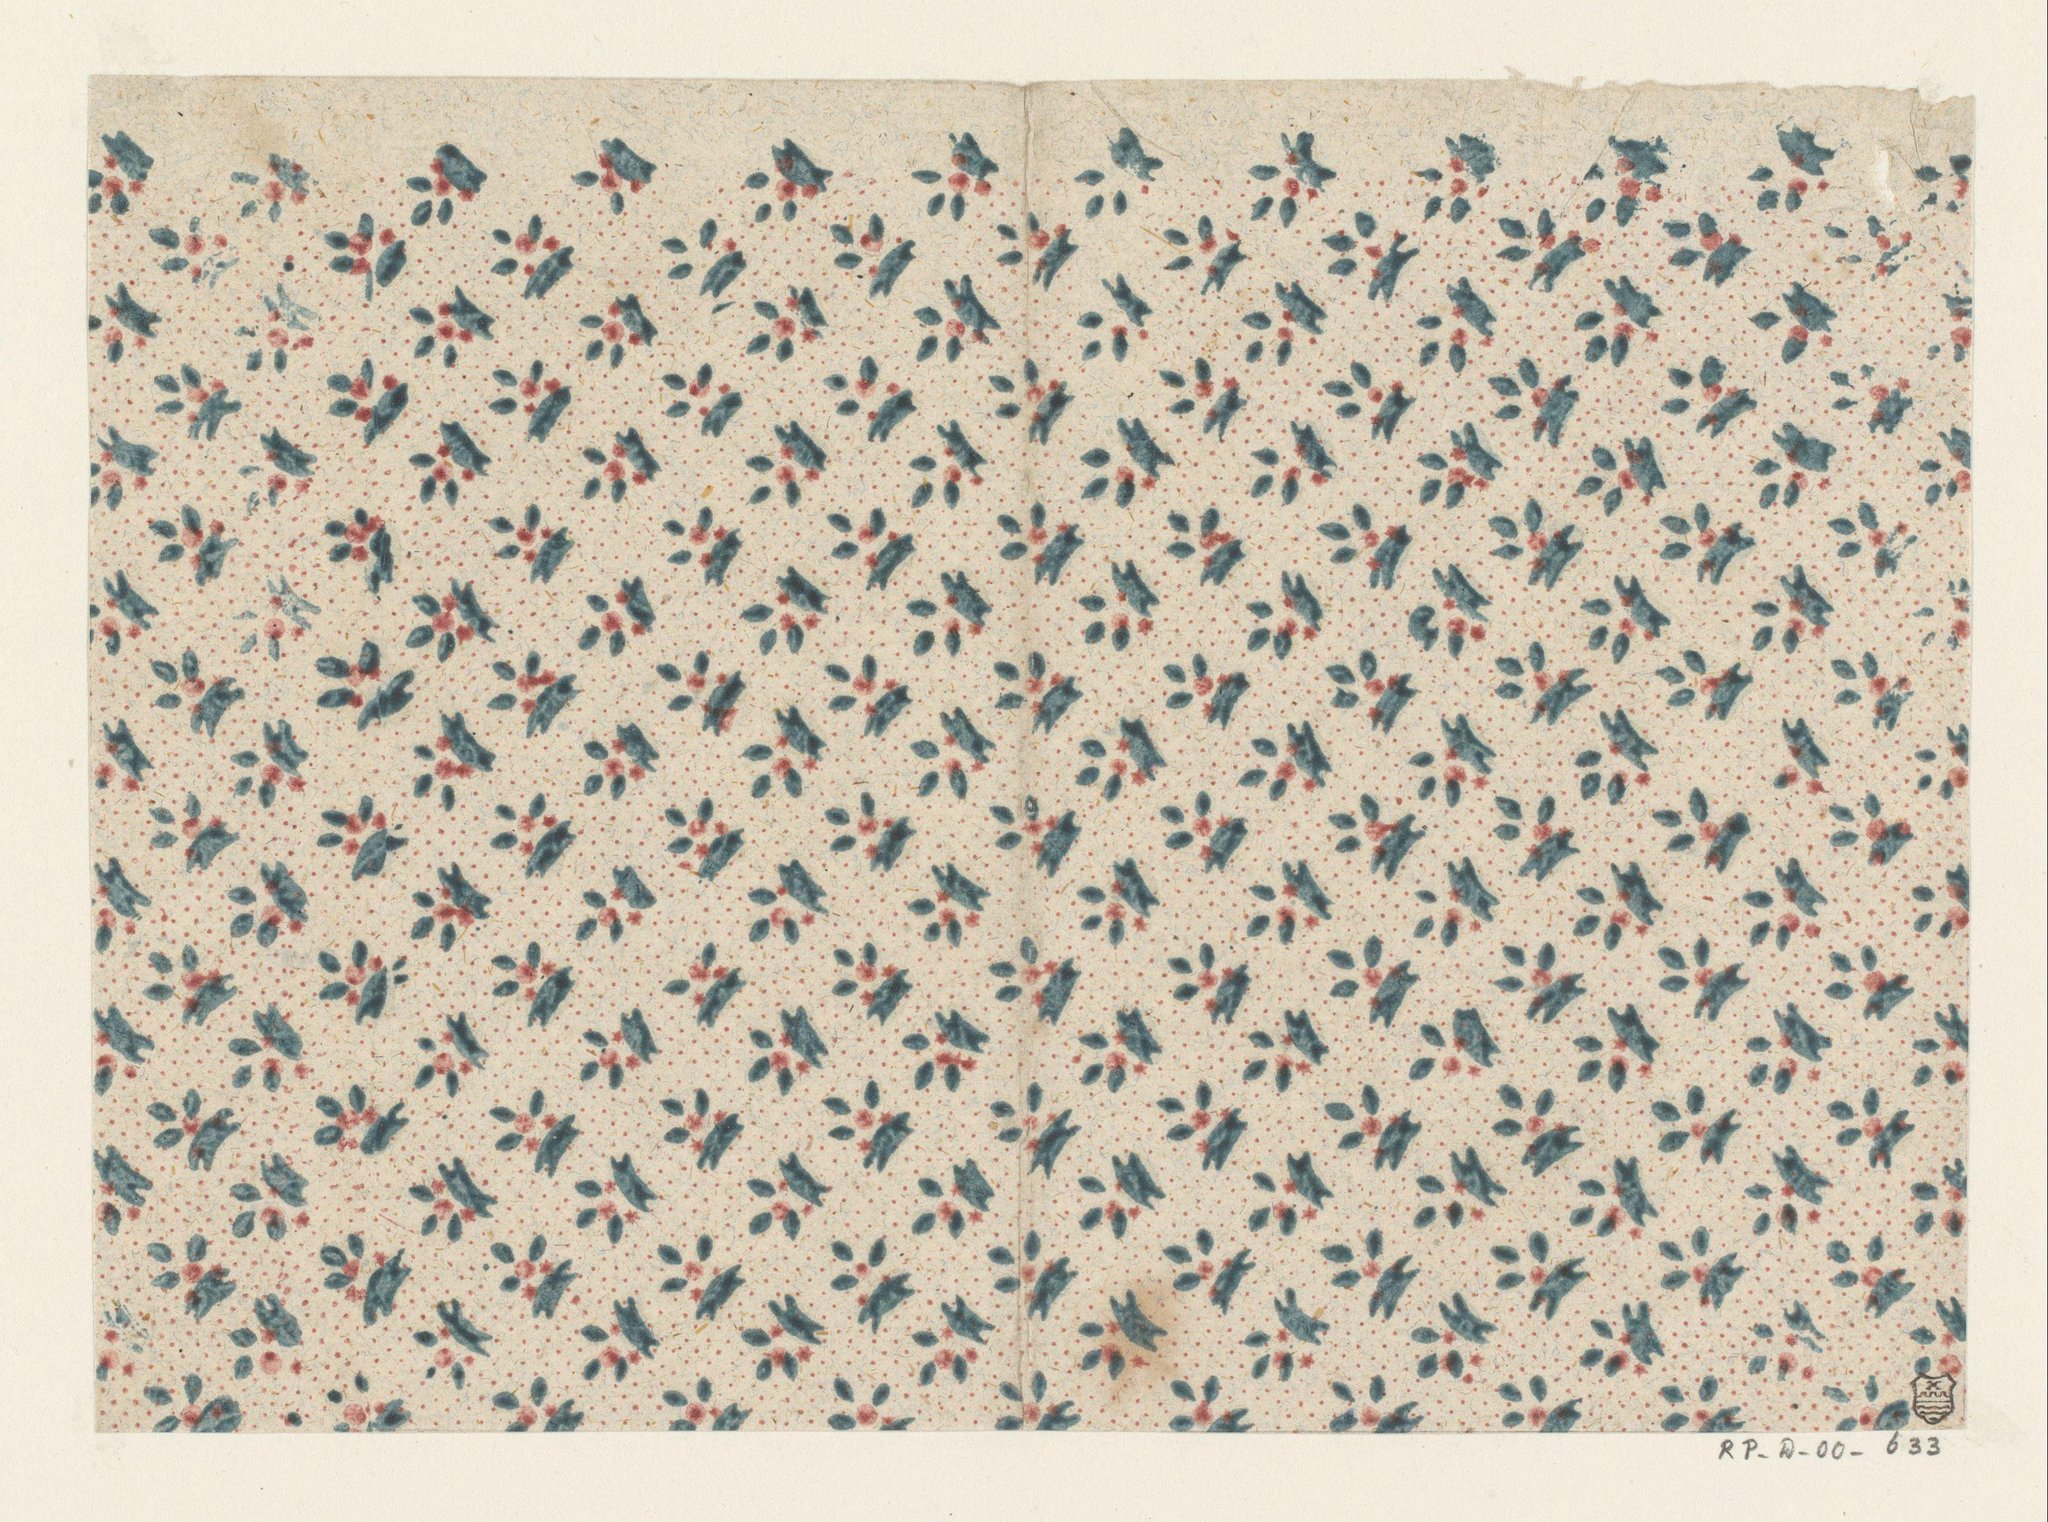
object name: wrapper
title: Blad met strooipatroon van bladmotief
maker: Anonymous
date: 1750-1900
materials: paper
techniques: printing block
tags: ornament derived from plant forms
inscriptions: collector's mark: Lugt 2760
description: Blad met strooipatroon van bladmotief op puntenfond. Gebruikt als omslag.